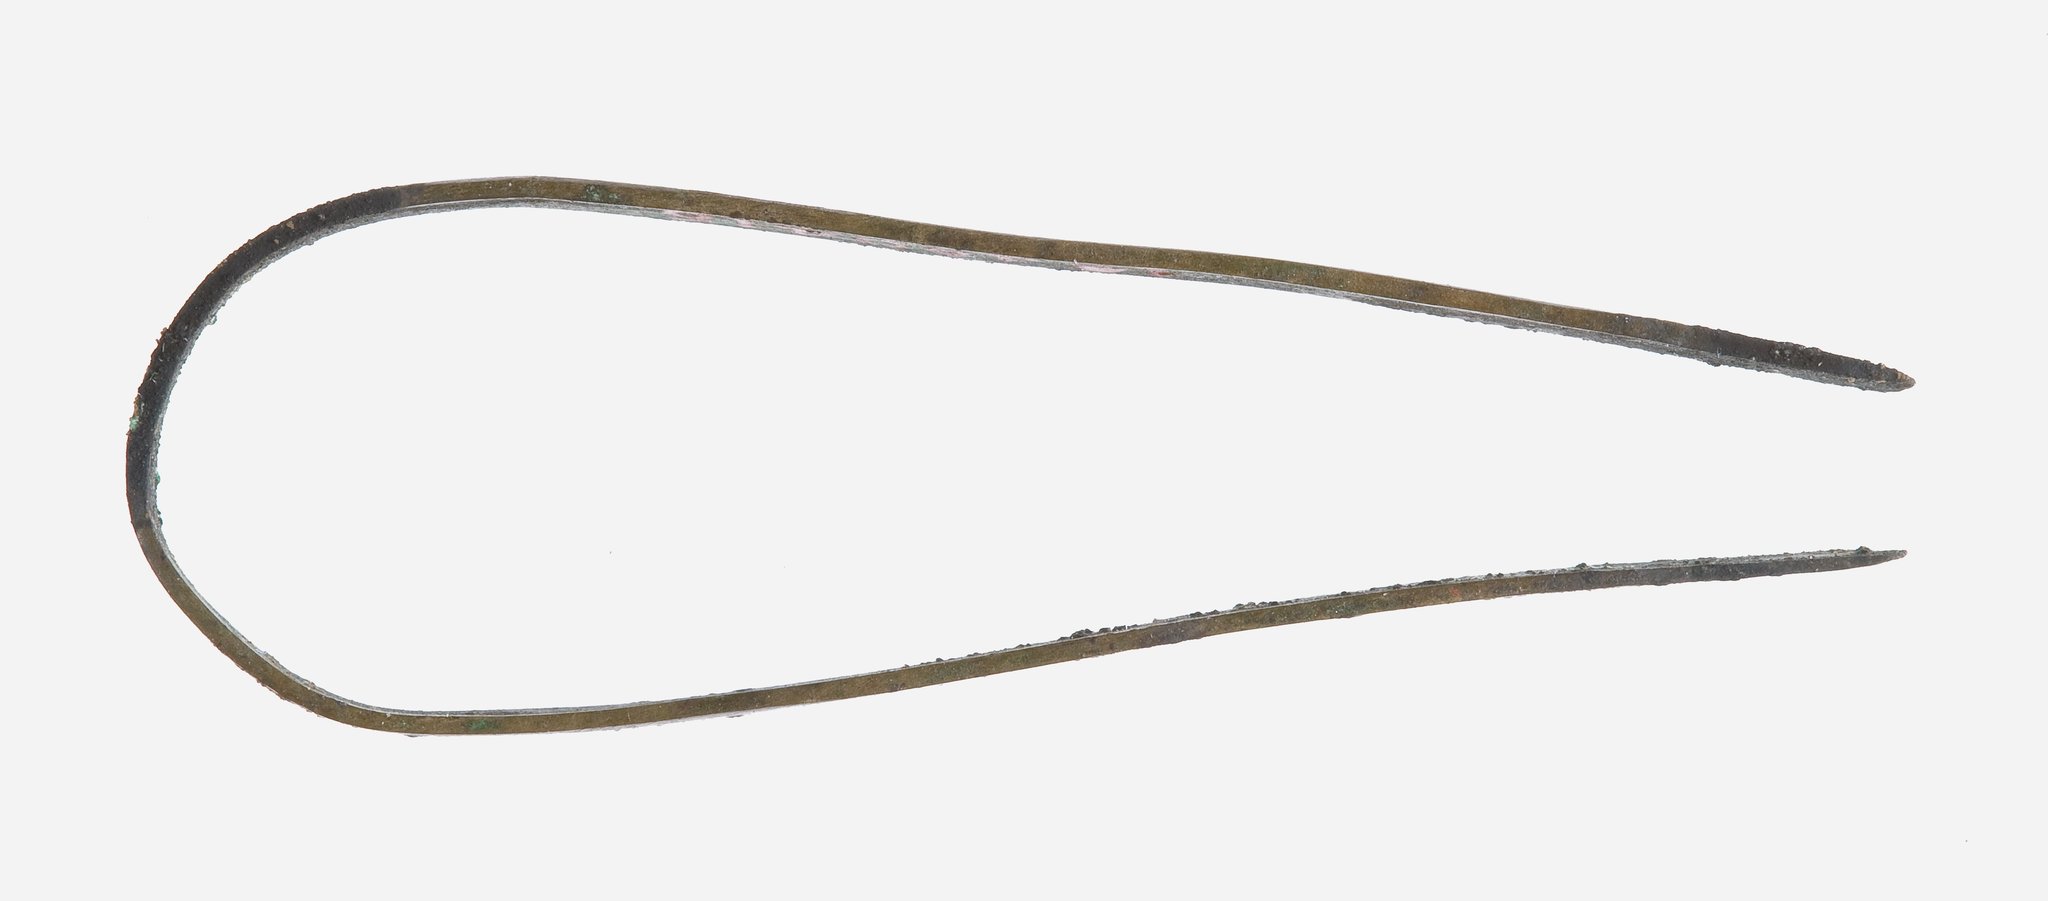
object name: tweezer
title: Tweezers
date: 1390-1352 BCE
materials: bronze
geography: egypt